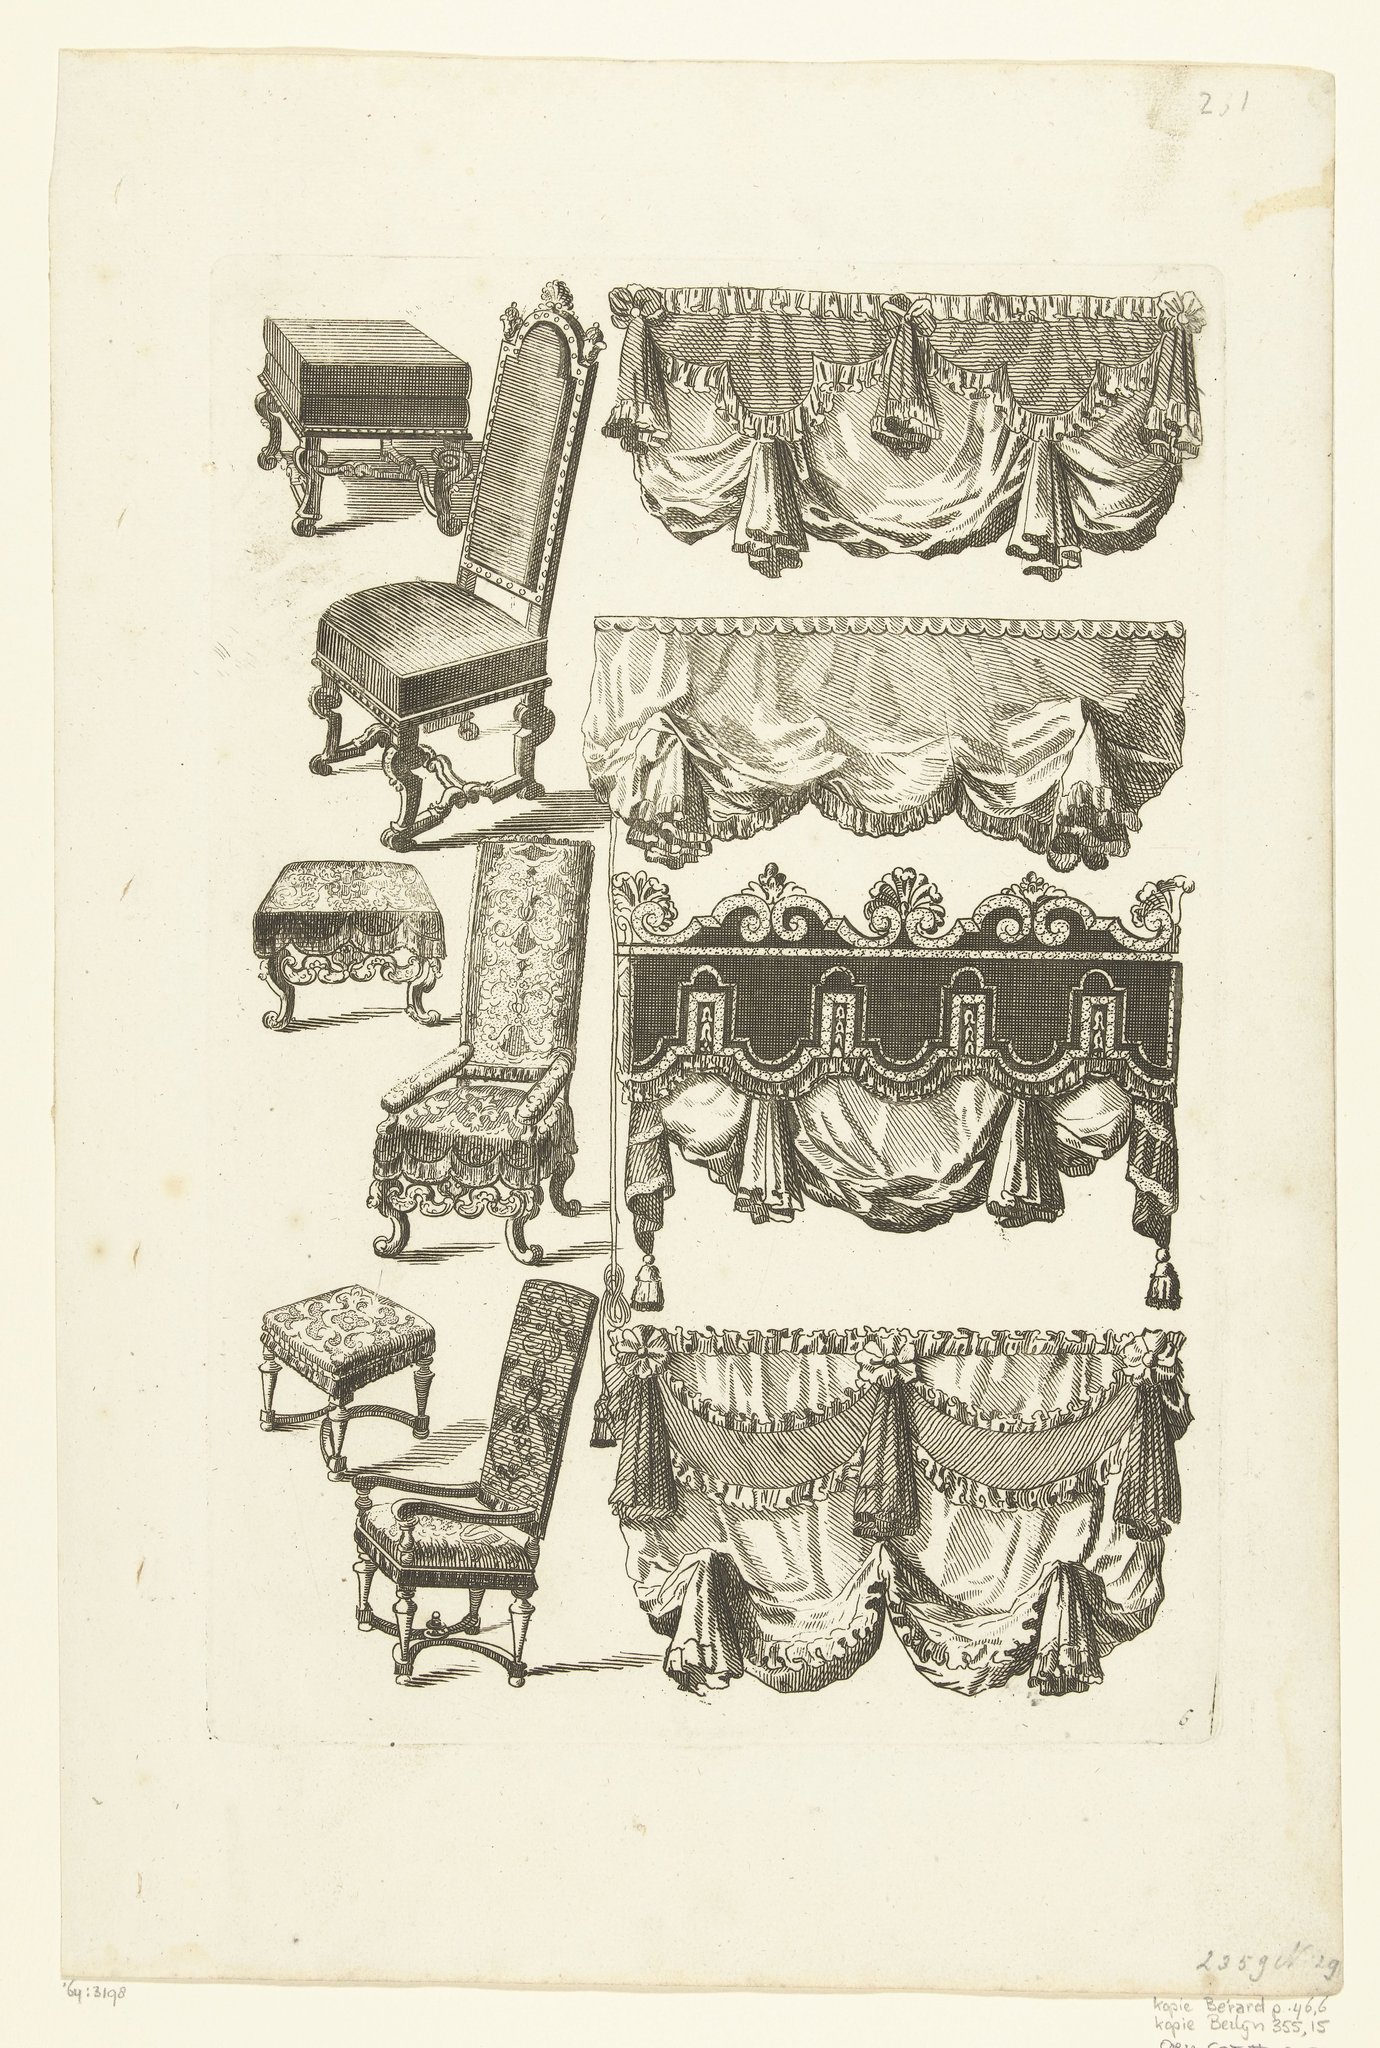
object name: ornament print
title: Vier randdecoraties van baldakijnen of vallen en drie paar stoelen met kruk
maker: Anonymous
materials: paper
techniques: etching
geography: netherlands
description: Tegenzijdige kopie naar blad uit de serie Second Liure Dappartements.